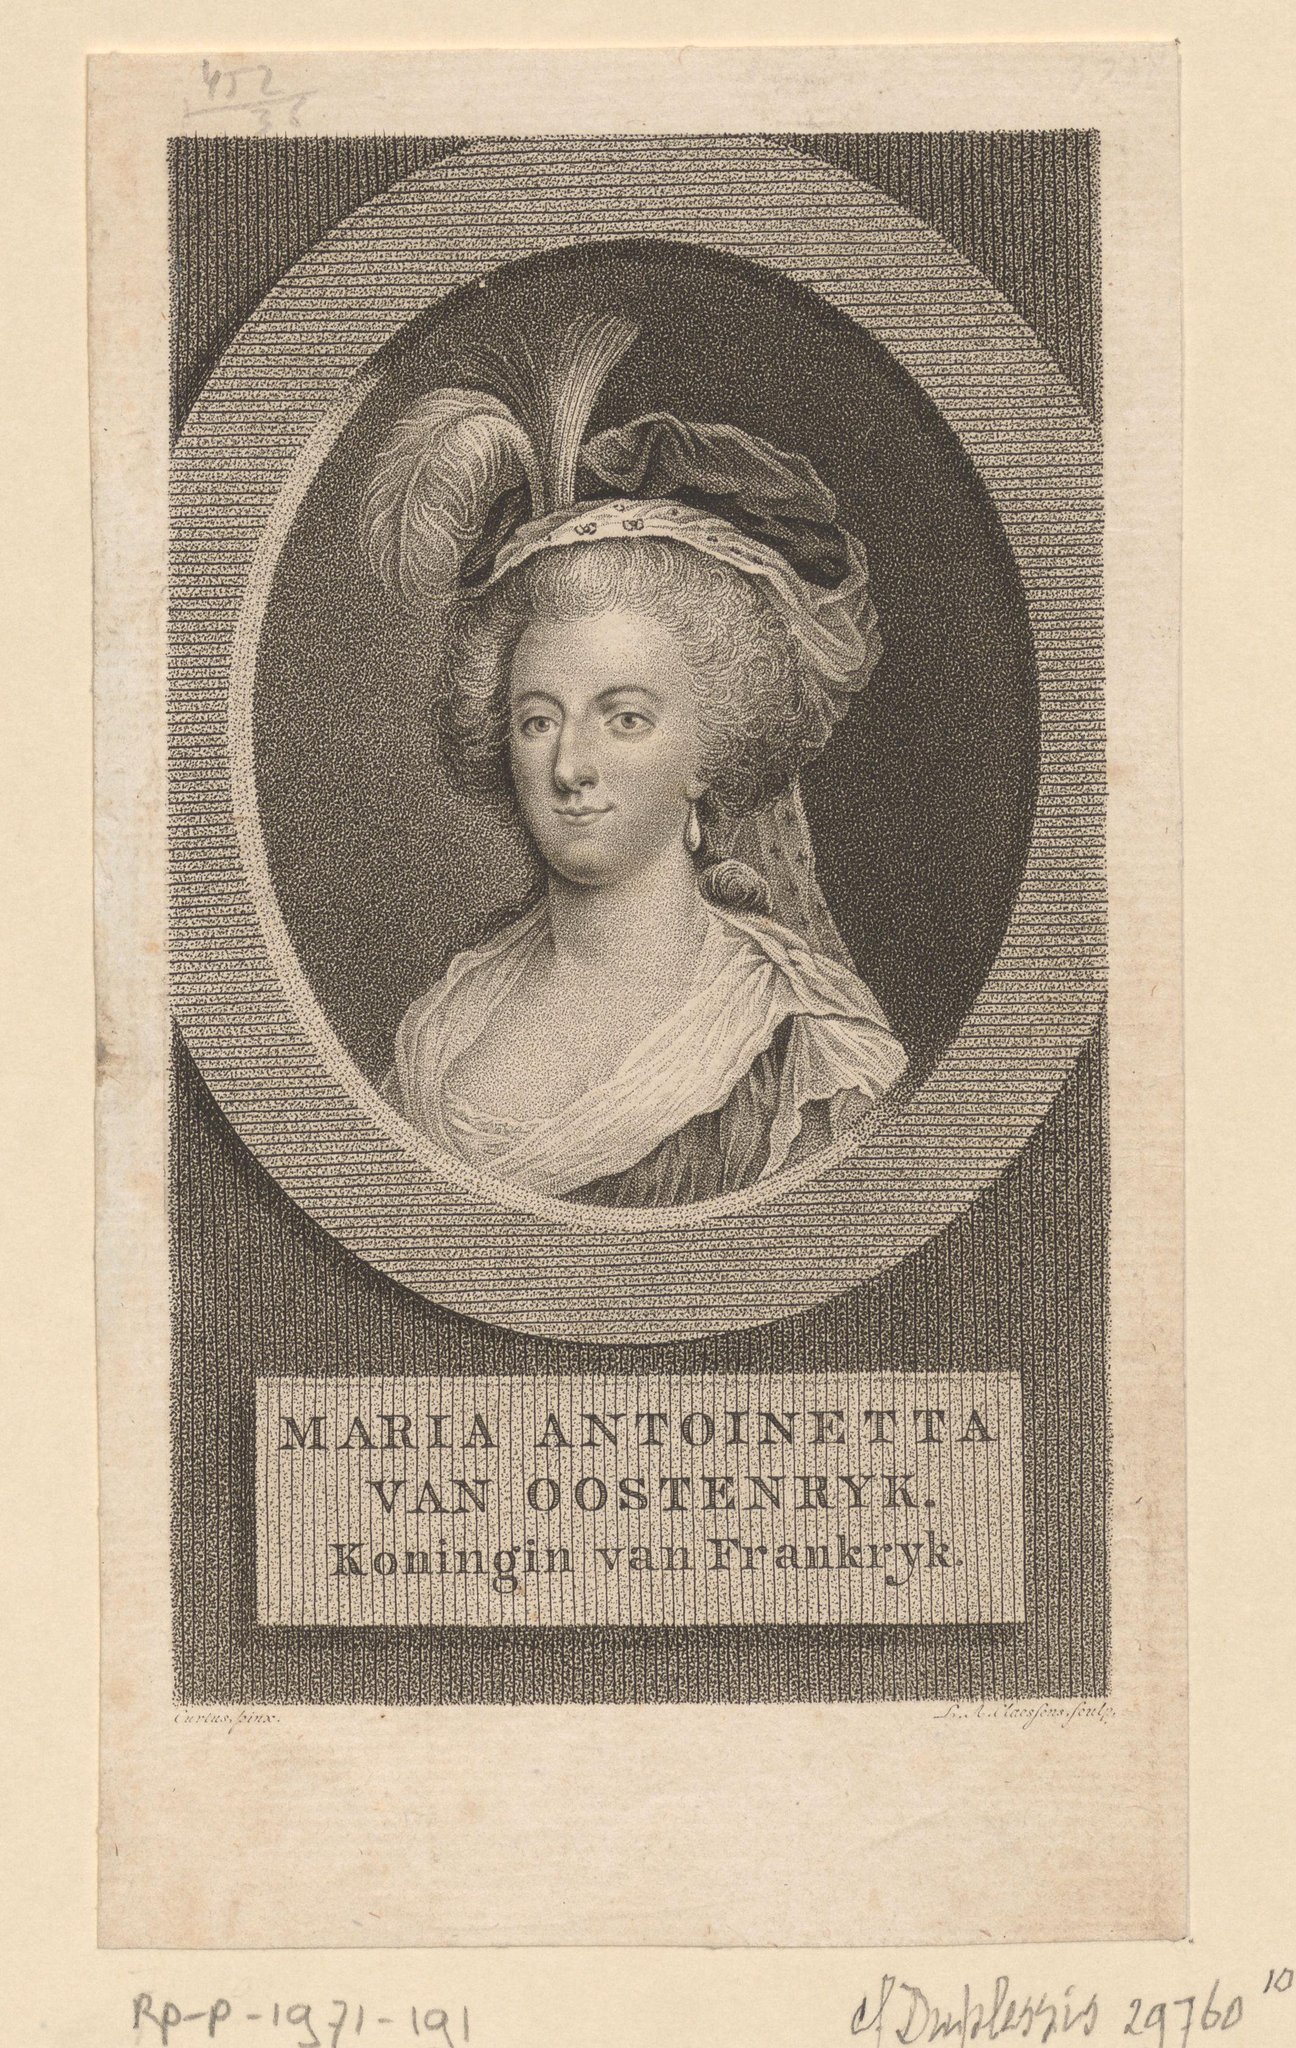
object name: book illustration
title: Portret van Marie Antoinette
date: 1794-1809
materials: paper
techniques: engraving, etching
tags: vienna, paris, marie antoinette, historical persons - bb - woman, ornament ~ medallion, queen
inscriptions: collector's mark: Lugt 2760, name: ‘Curtus’, collector's mark: Lugt 2228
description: Prent waarschijnlijk uit een deel van: Tafereelen van de staatsomwenteling in Frankrijk. Amsterdam: Johannes Allart, 1794-1809.